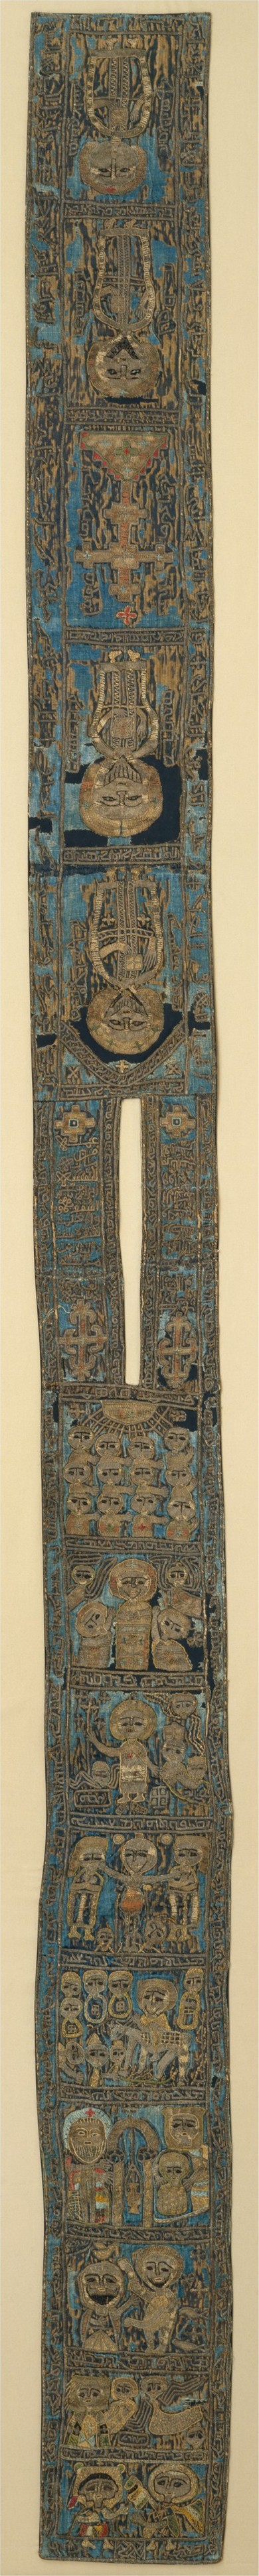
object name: batrashil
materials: linen, metal thread, silk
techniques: backing, embroidery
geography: syria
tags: christ,evangelists